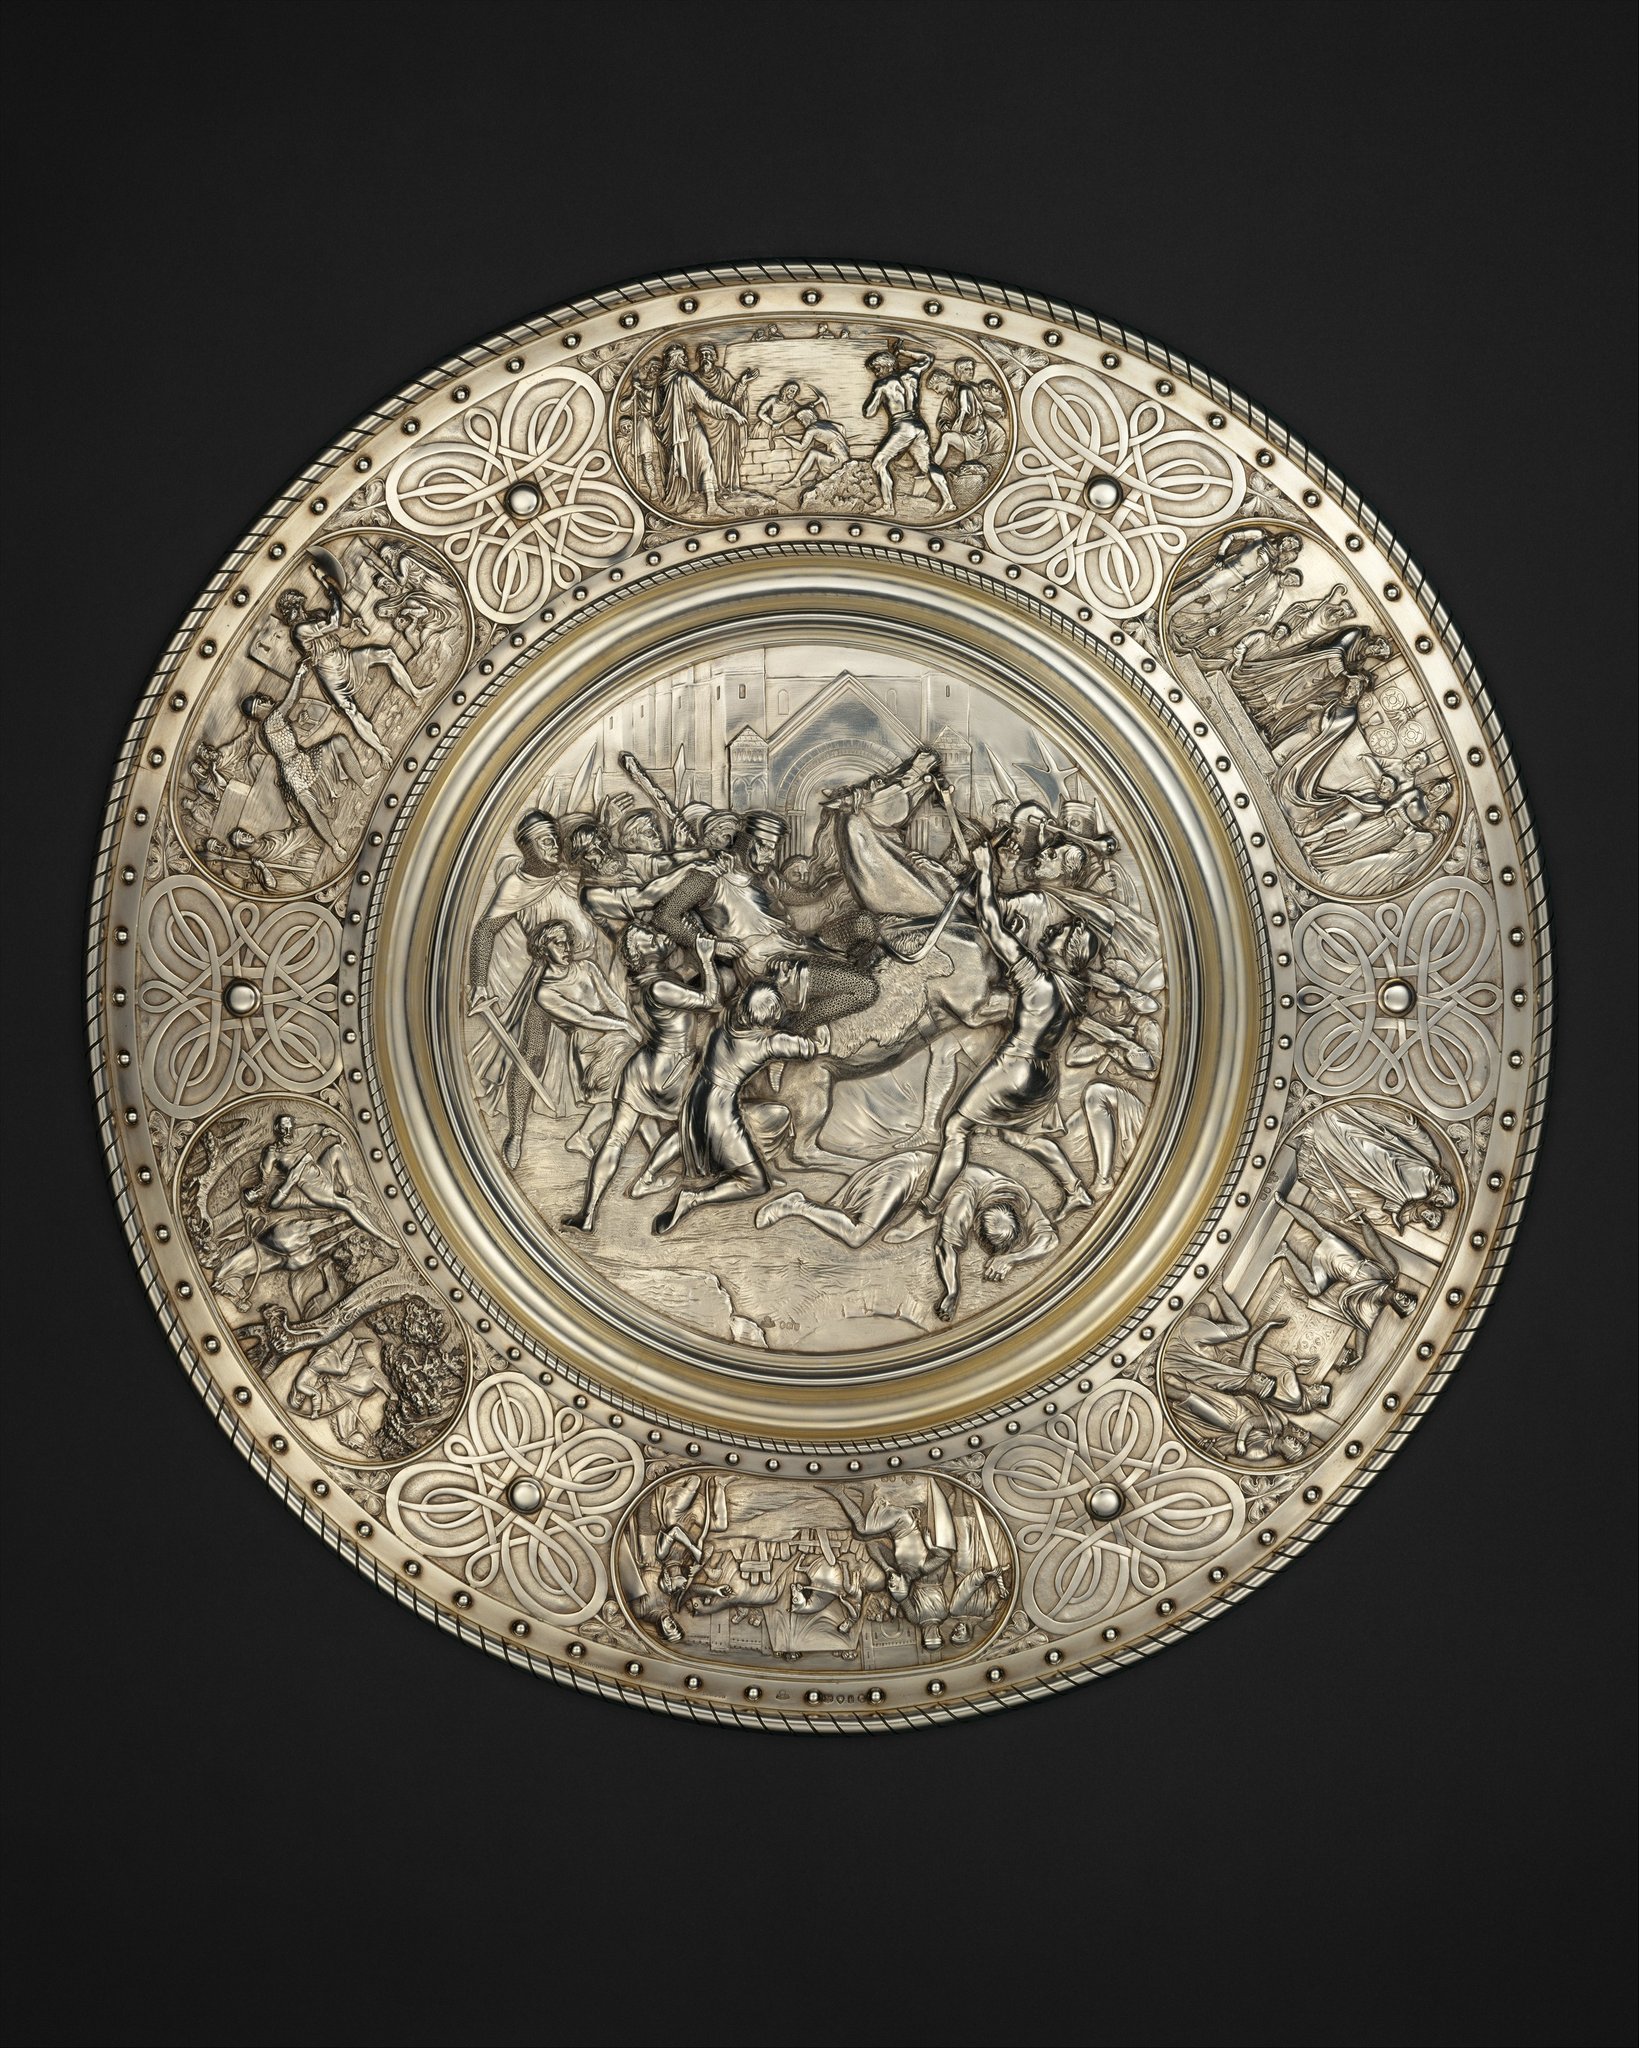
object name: shield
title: The Stockbridge Cup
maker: henry hugh armstead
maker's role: designer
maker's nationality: british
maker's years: 1828-1905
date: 1870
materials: gilt, silver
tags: battles,men,horses